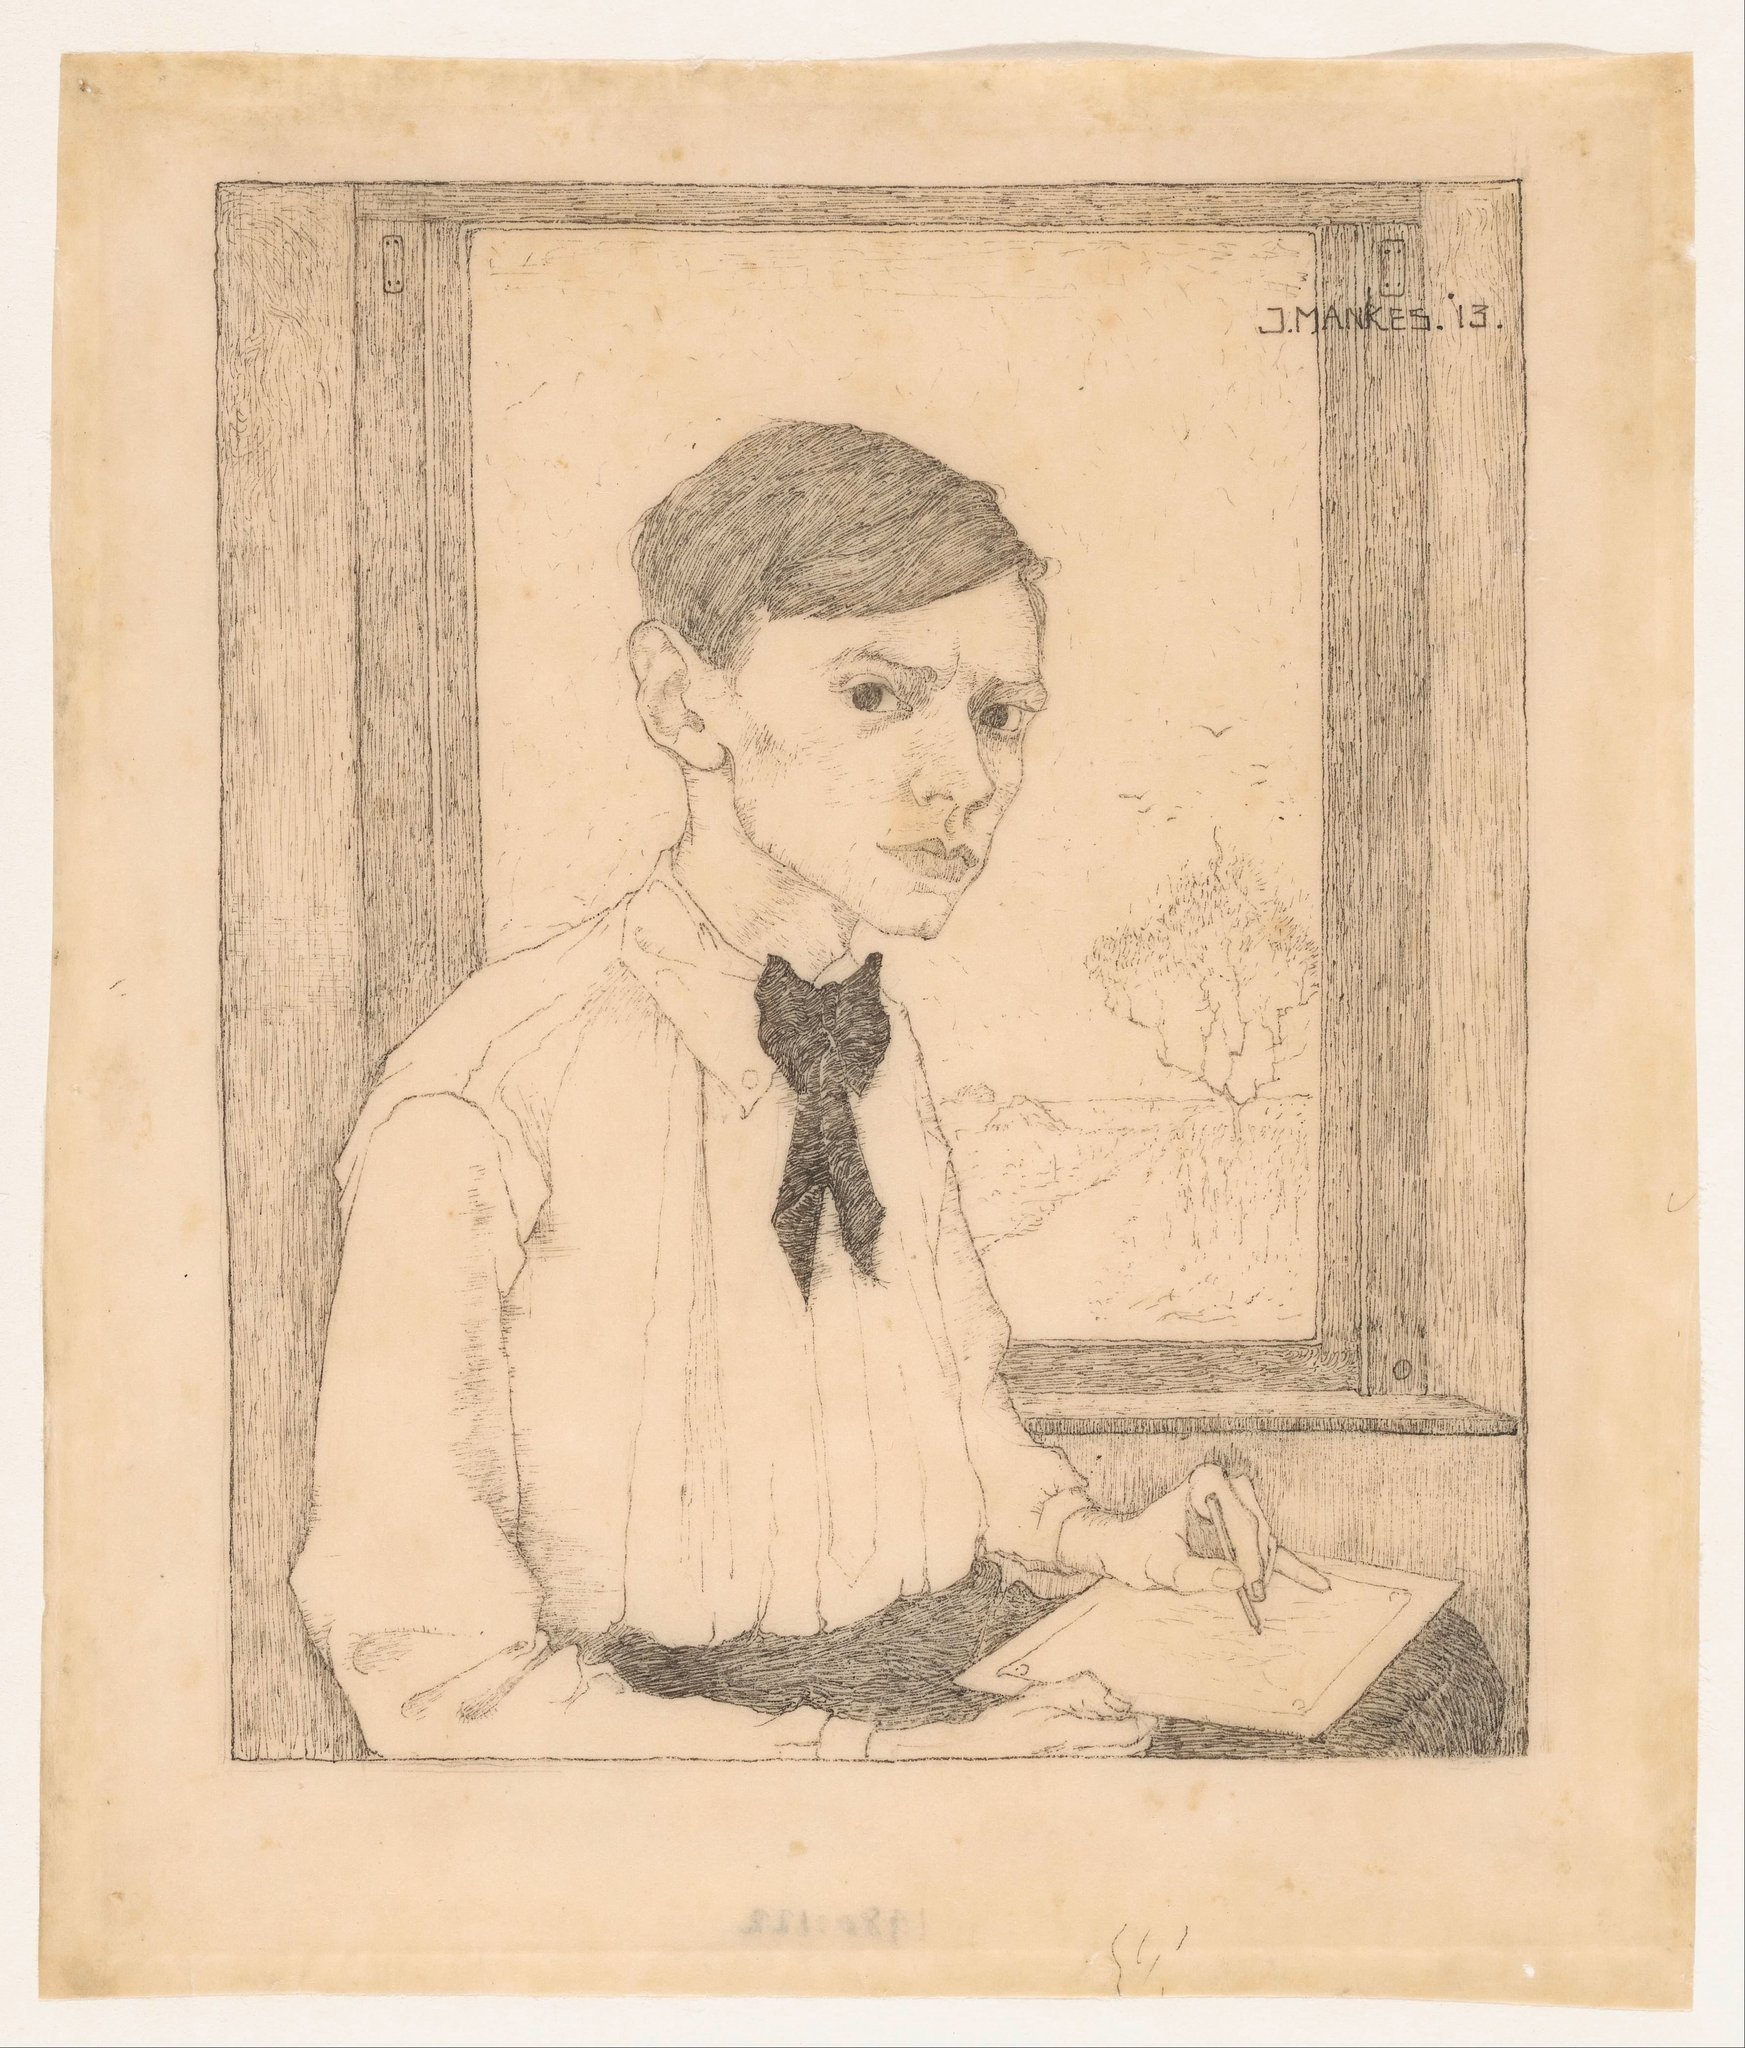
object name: design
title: Zelfportret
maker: jan mankes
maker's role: draughtsman, painter, print maker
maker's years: 1889-1920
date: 1913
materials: ink, parchment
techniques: pen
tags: painter, draughtsman, jan mankes, historical persons, portrait, self-portrait of artist, portrait, self-portrait of draughtsman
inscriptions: date